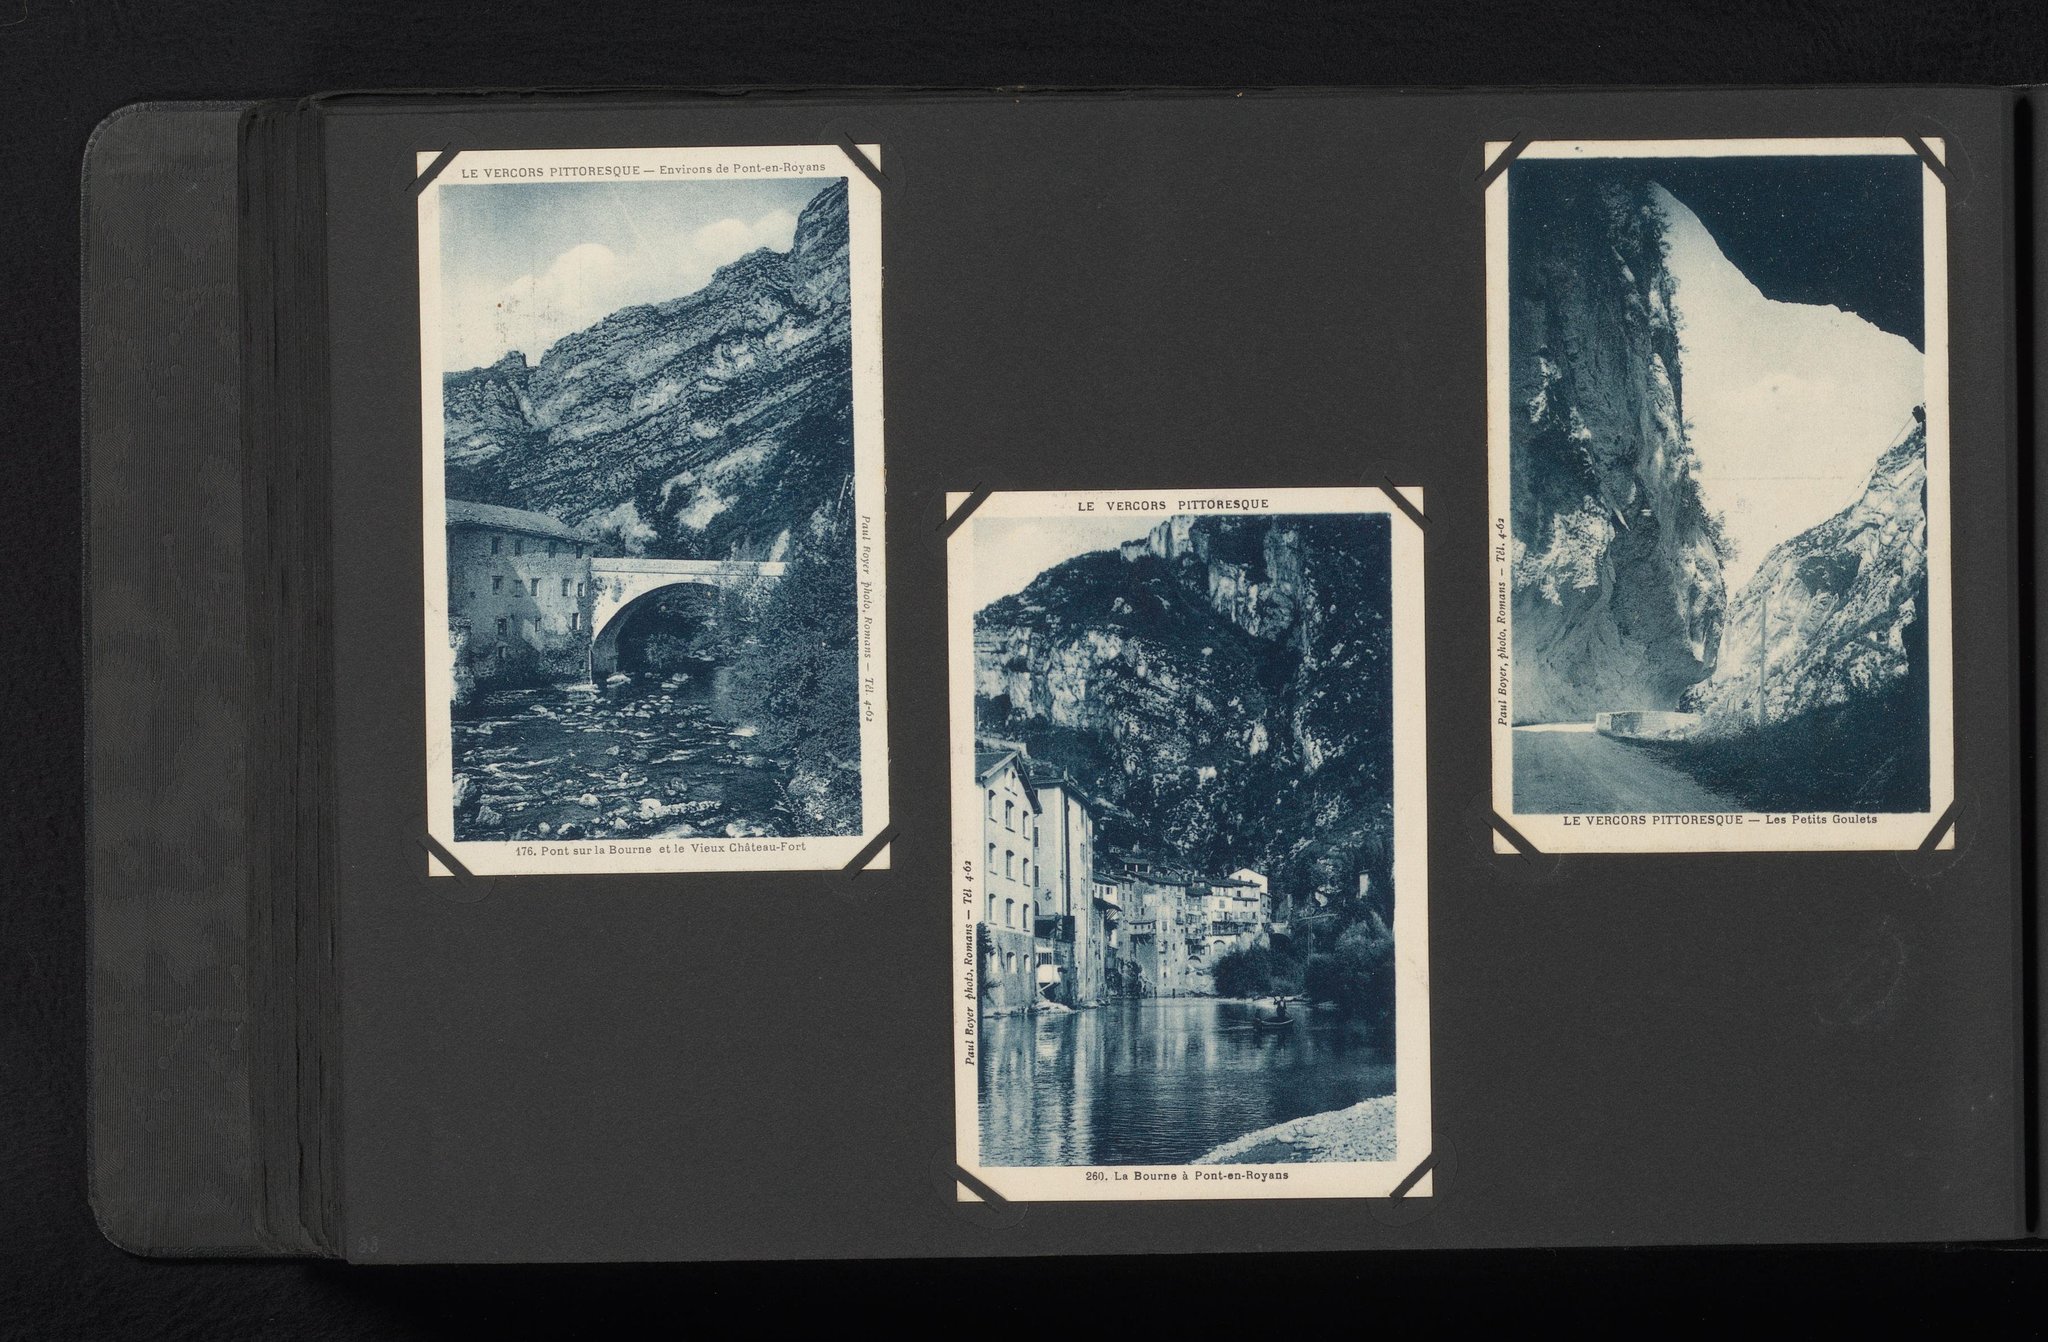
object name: album leaf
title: Drie fotomechanische prentbriefkaarten van Pont-en-Royans en omgeving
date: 1908-1929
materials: cardboard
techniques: photograph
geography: pont-en-royans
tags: village, mountains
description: Deze prenten maken deel uit van een album.